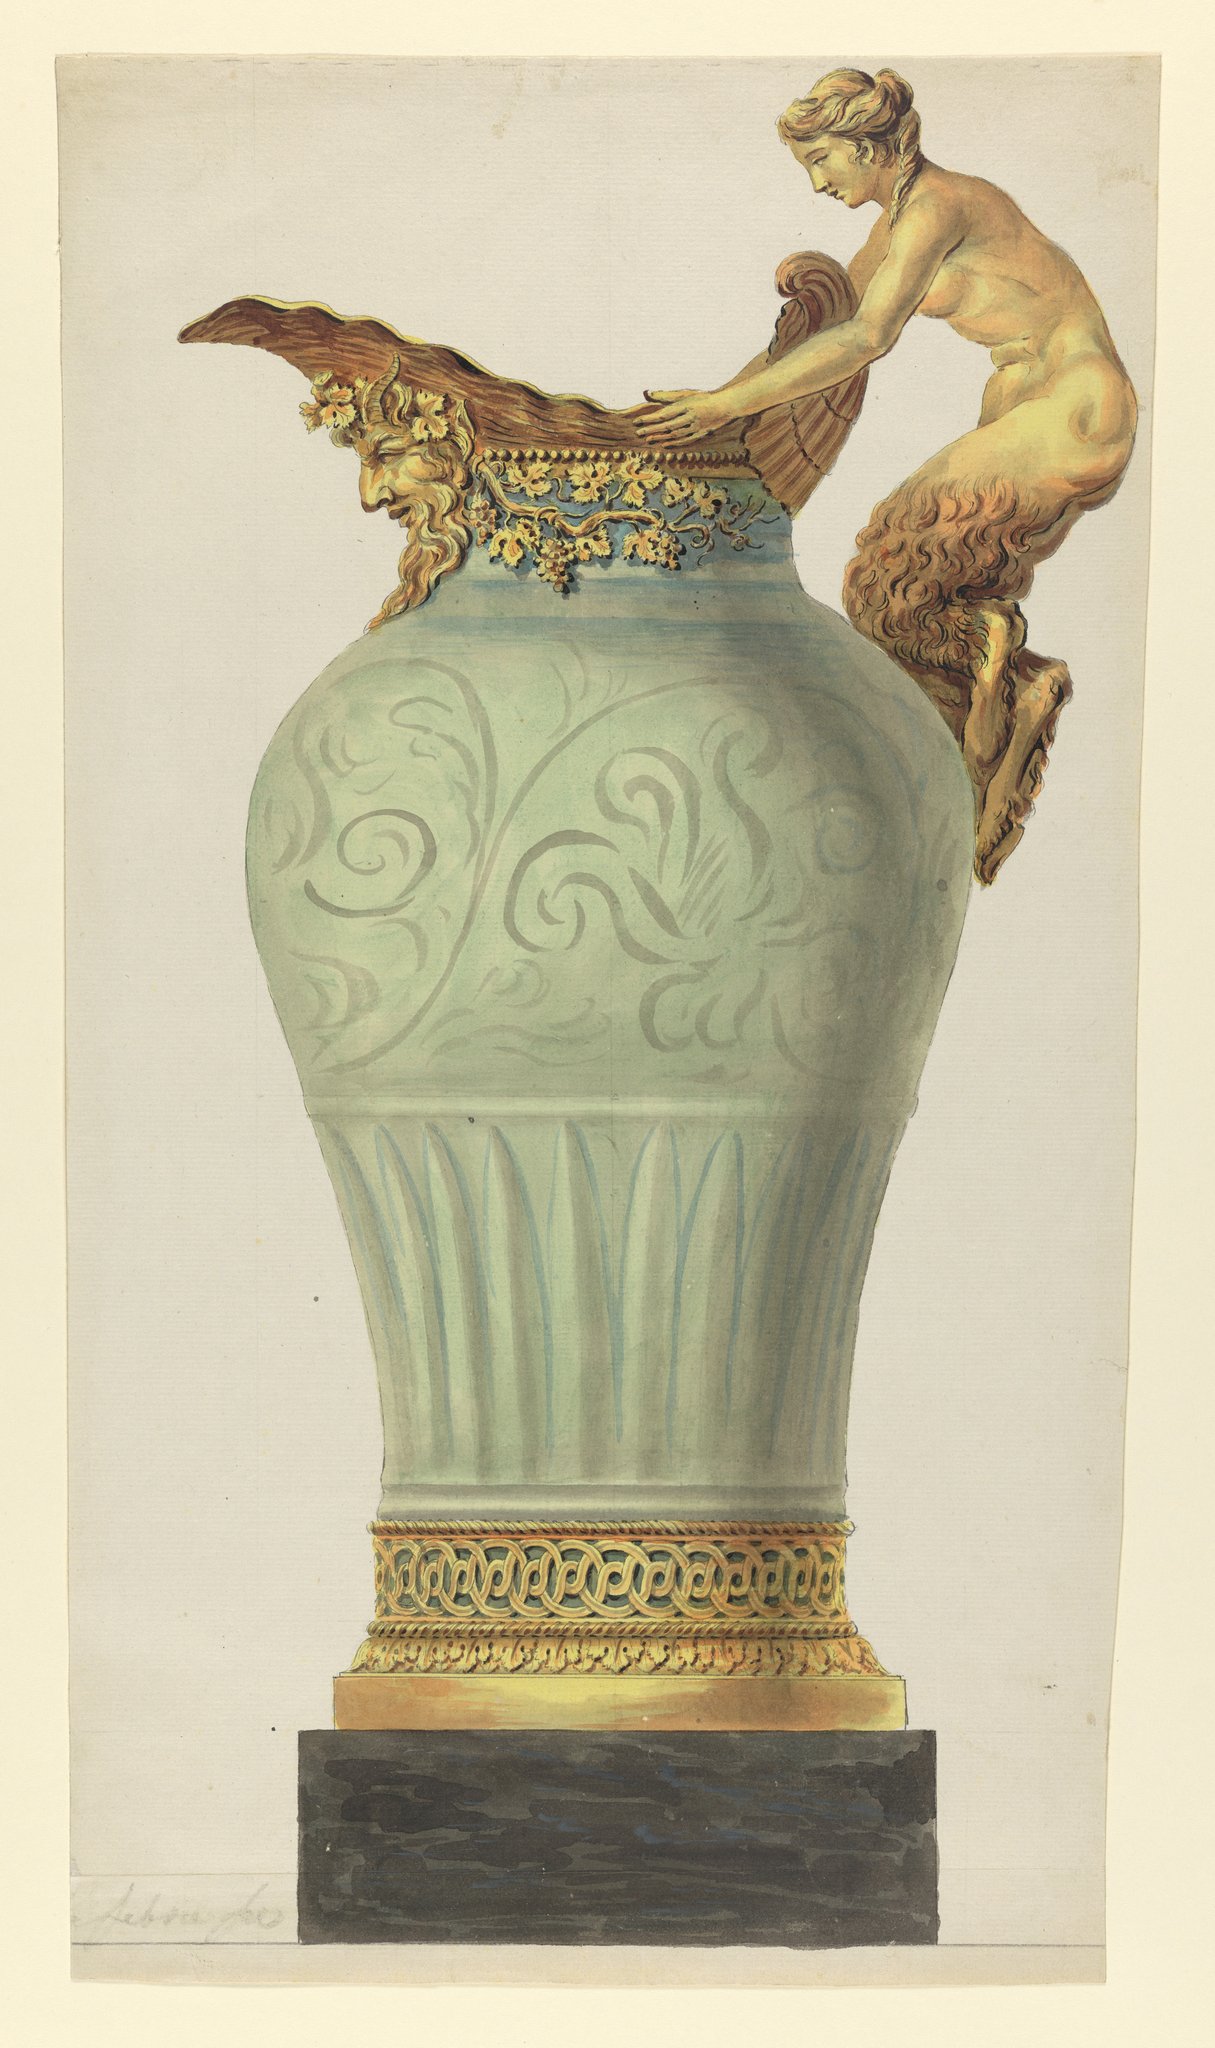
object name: drawing ornament architecture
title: Drawing of a Chinese Celadon Vase with Gilt-Bronze Mounts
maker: anonymous, french, 18th century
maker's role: artist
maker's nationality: french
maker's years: 1700-1800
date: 1782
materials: graphite, ink, watercolor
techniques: pen, drawing